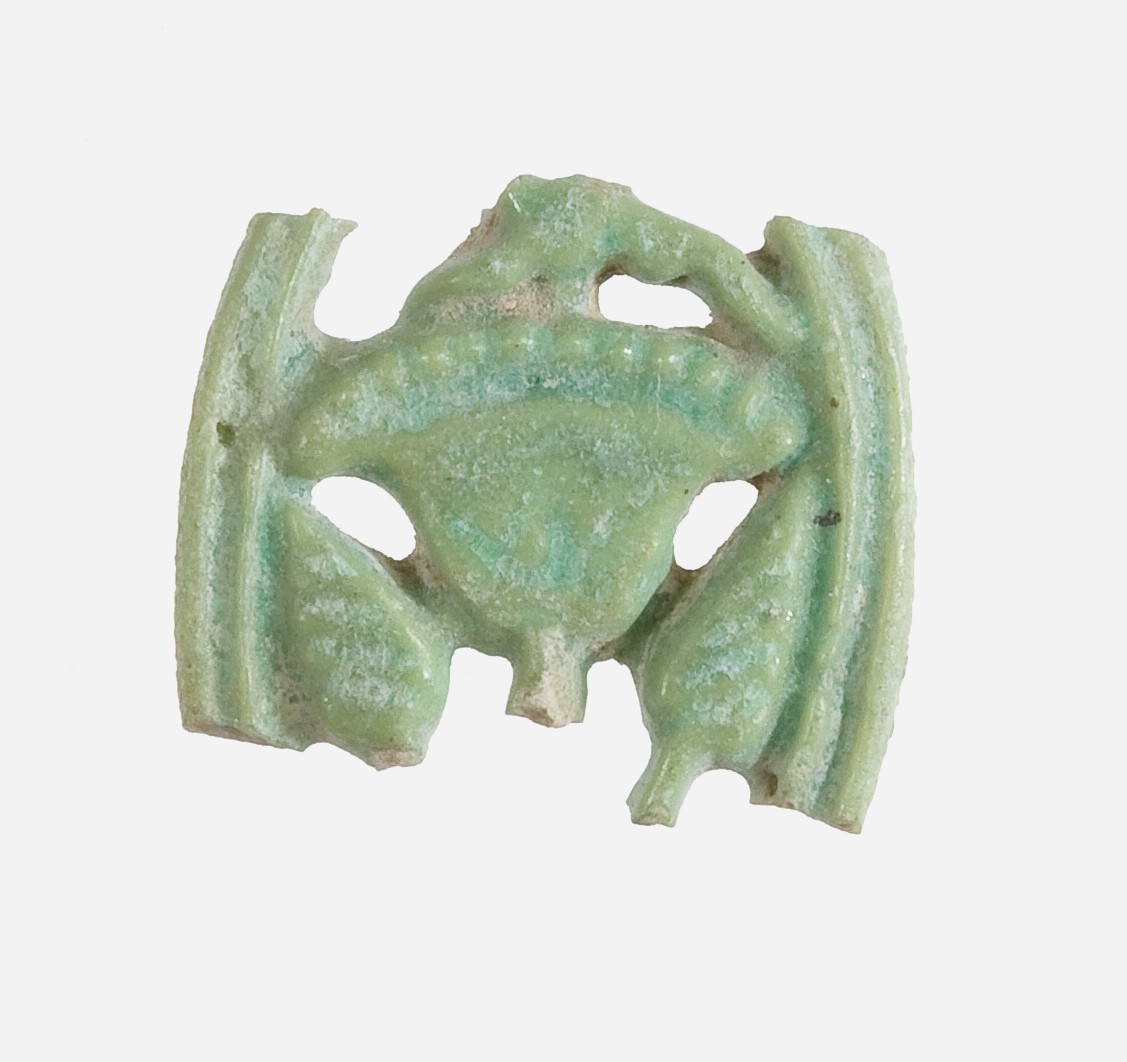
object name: ring fragment, floral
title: Ring Fragment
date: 1390-1352 BCE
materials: faience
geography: egypt